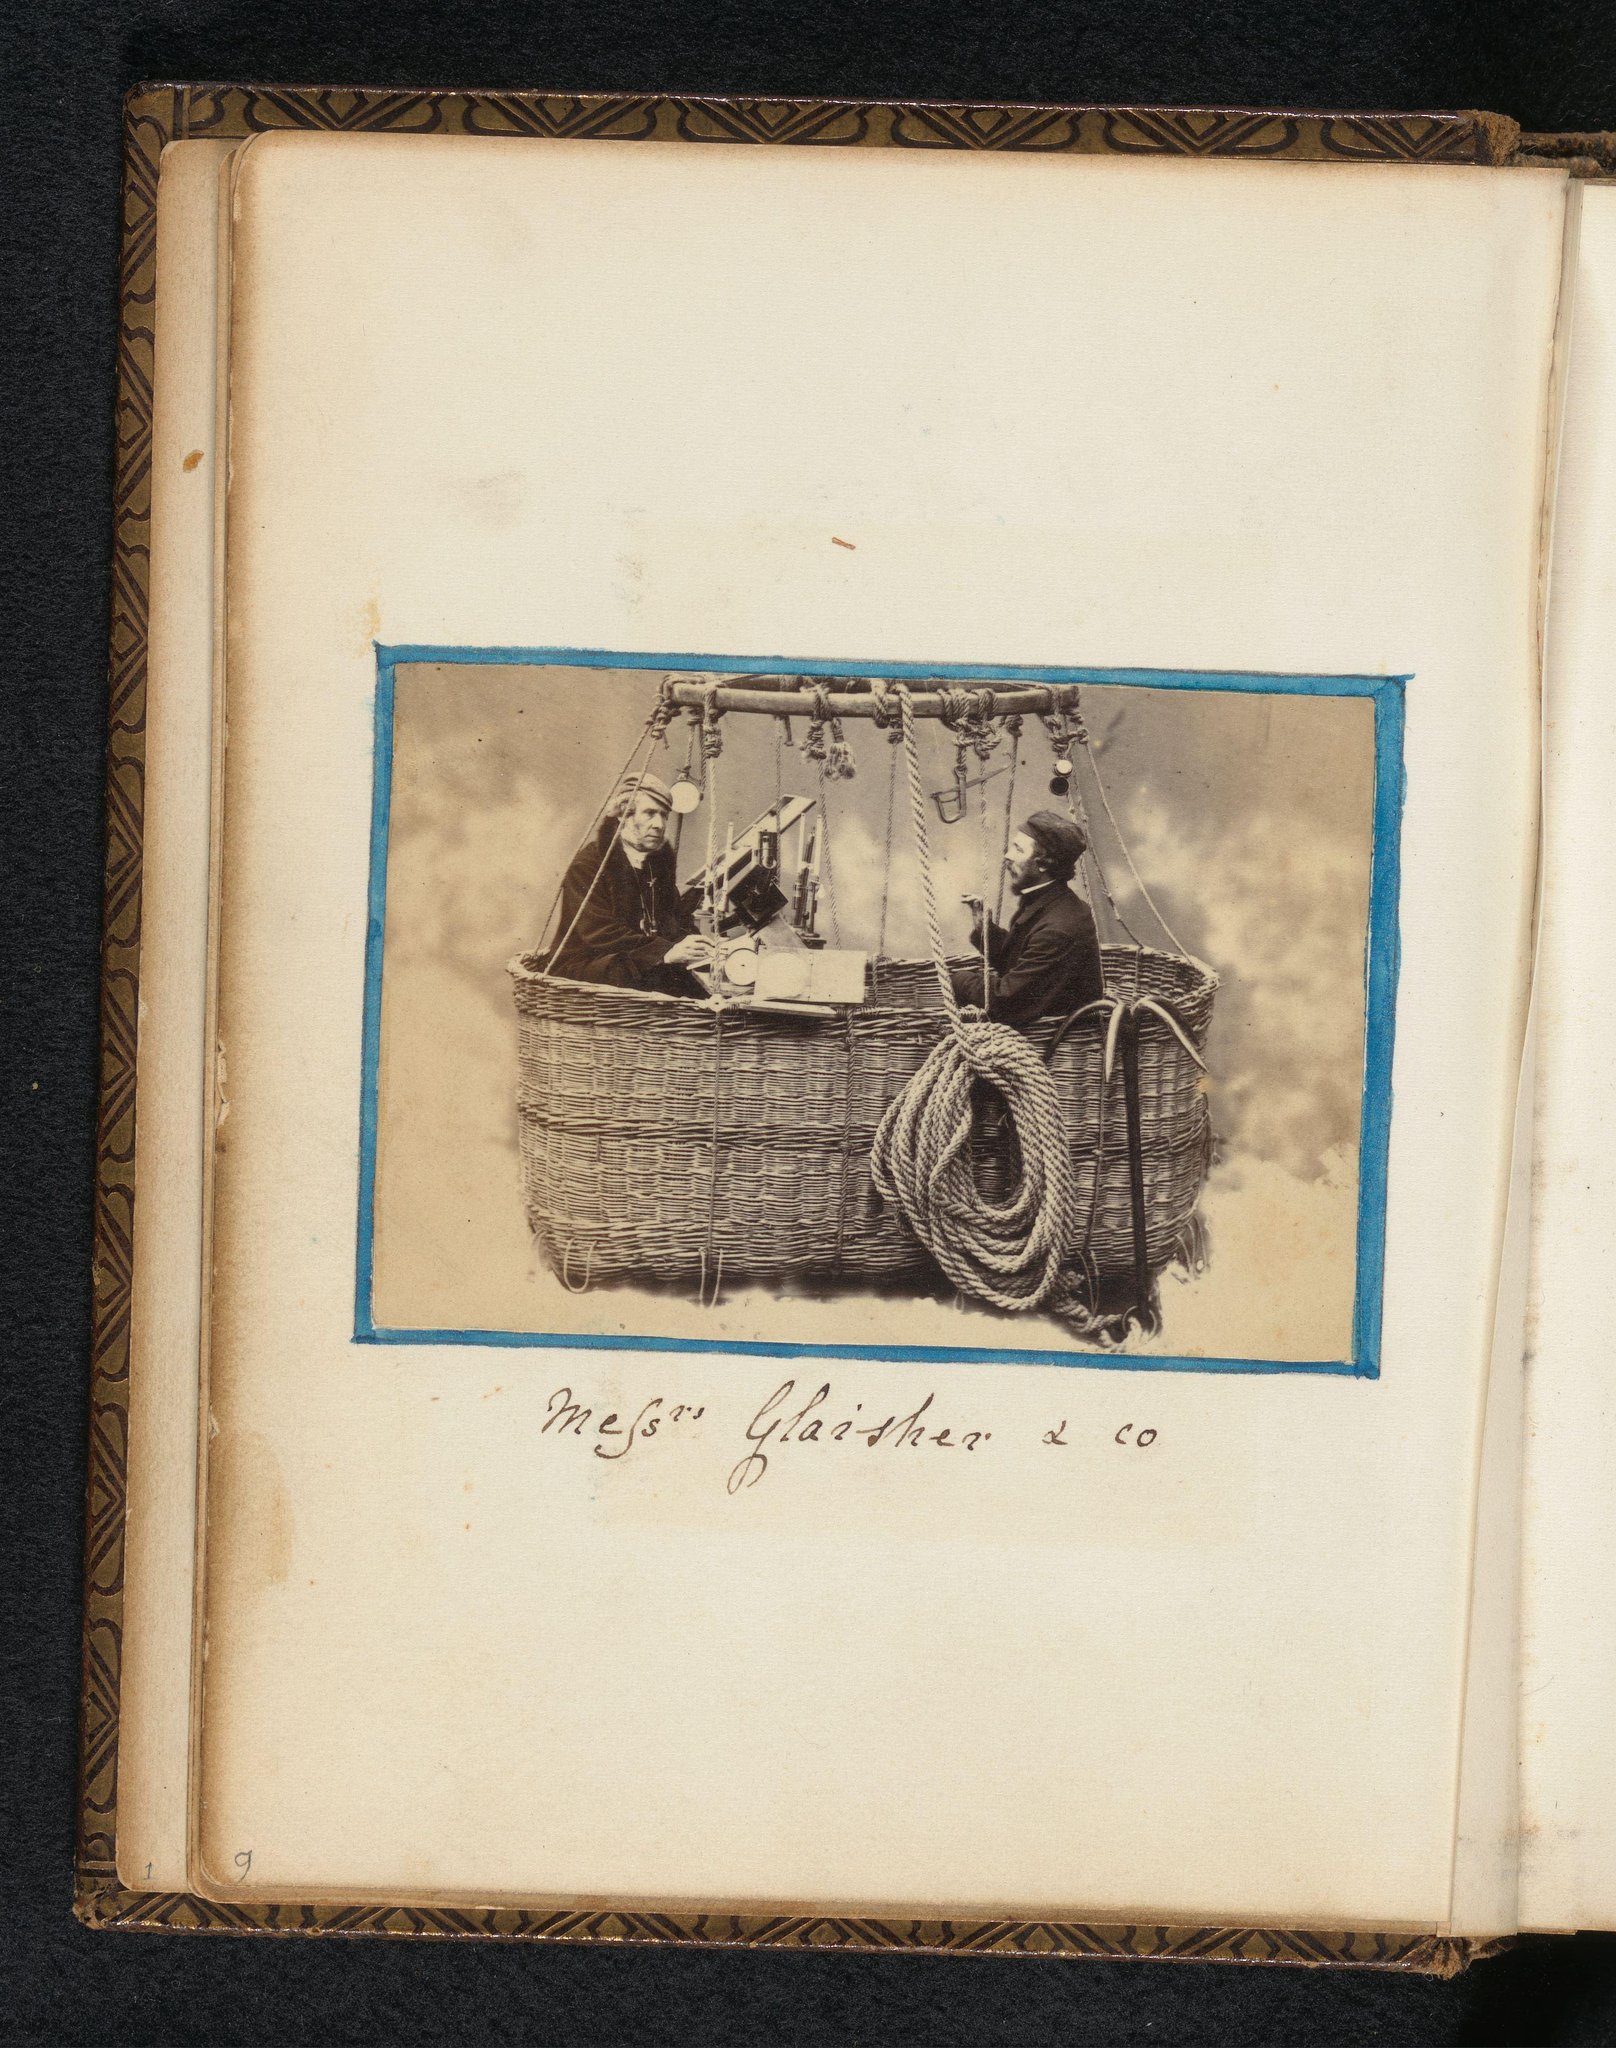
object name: album leaf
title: Messrs. Glaisher & co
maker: Anonymous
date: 1864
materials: cardboard, photographic support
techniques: albumen print, aquarelle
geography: england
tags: james glaisher, balloon flight (sport), balloon (aviation)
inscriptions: annotation: ‘Mess.rs Glaisher & co’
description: James Glaisher en Henry Coxwell in een luchtballon. Foto op albumblad in album met 68 foto's merendeels met geaquarelleerde randversieringen. Het zijn voornamelijk portretten op carte-de-visite formaat.